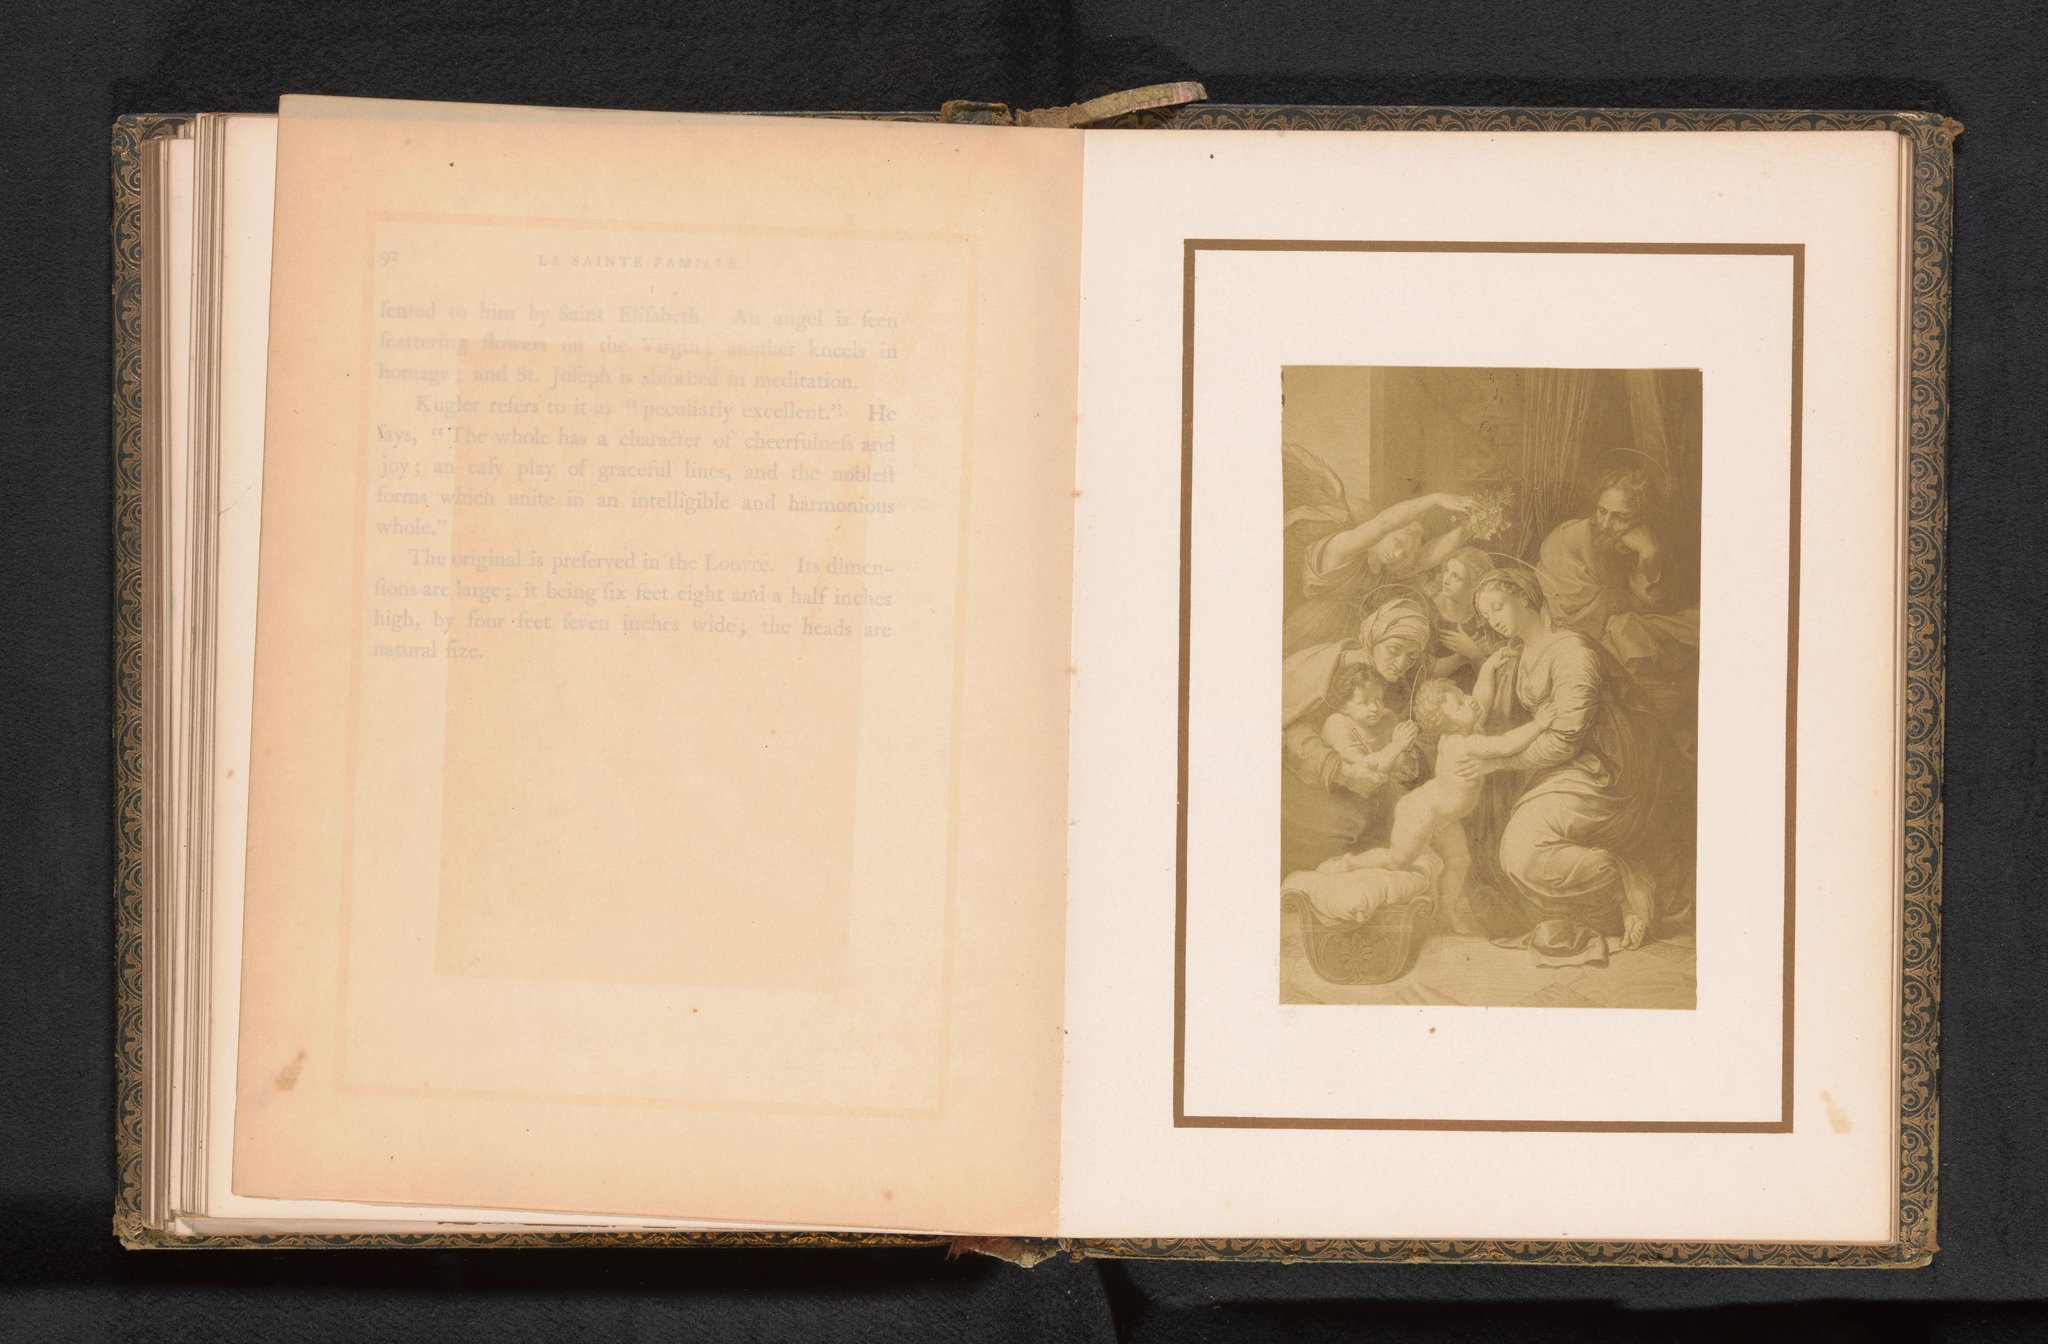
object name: reproduction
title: Fotoreproductie van een prent naar een schilderij, voorstellende de Heilige Familie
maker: e. hufnagel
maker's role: fotograaf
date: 1855-1860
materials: photographic support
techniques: albumen print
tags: holy family, and derived representations